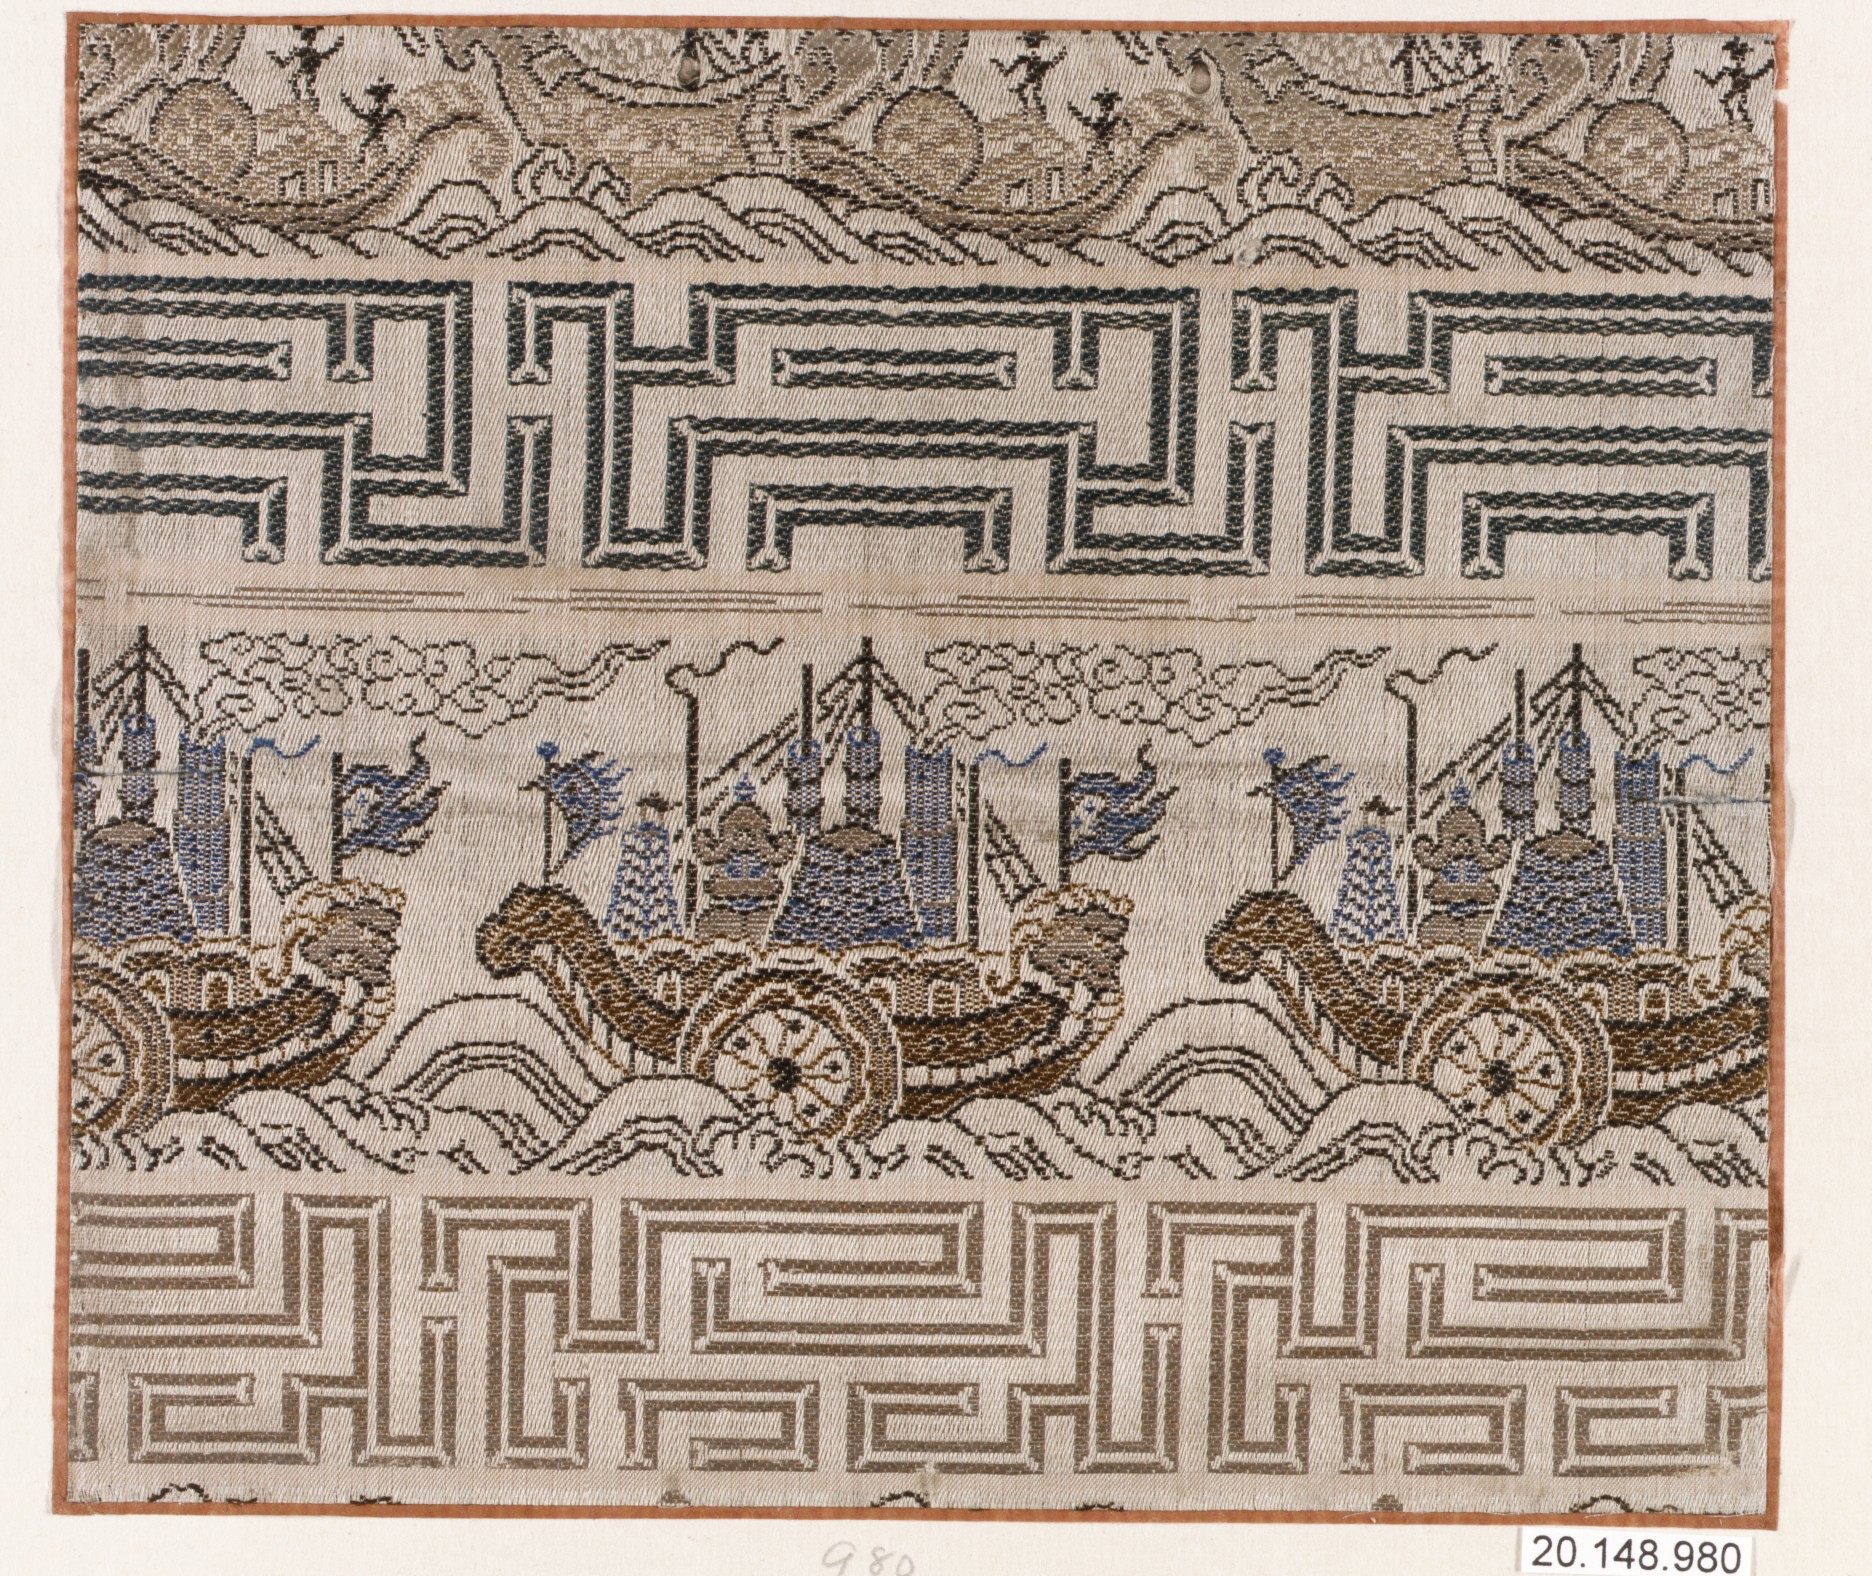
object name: piece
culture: japanese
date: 1801-1900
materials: silk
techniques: compound weave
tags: ships